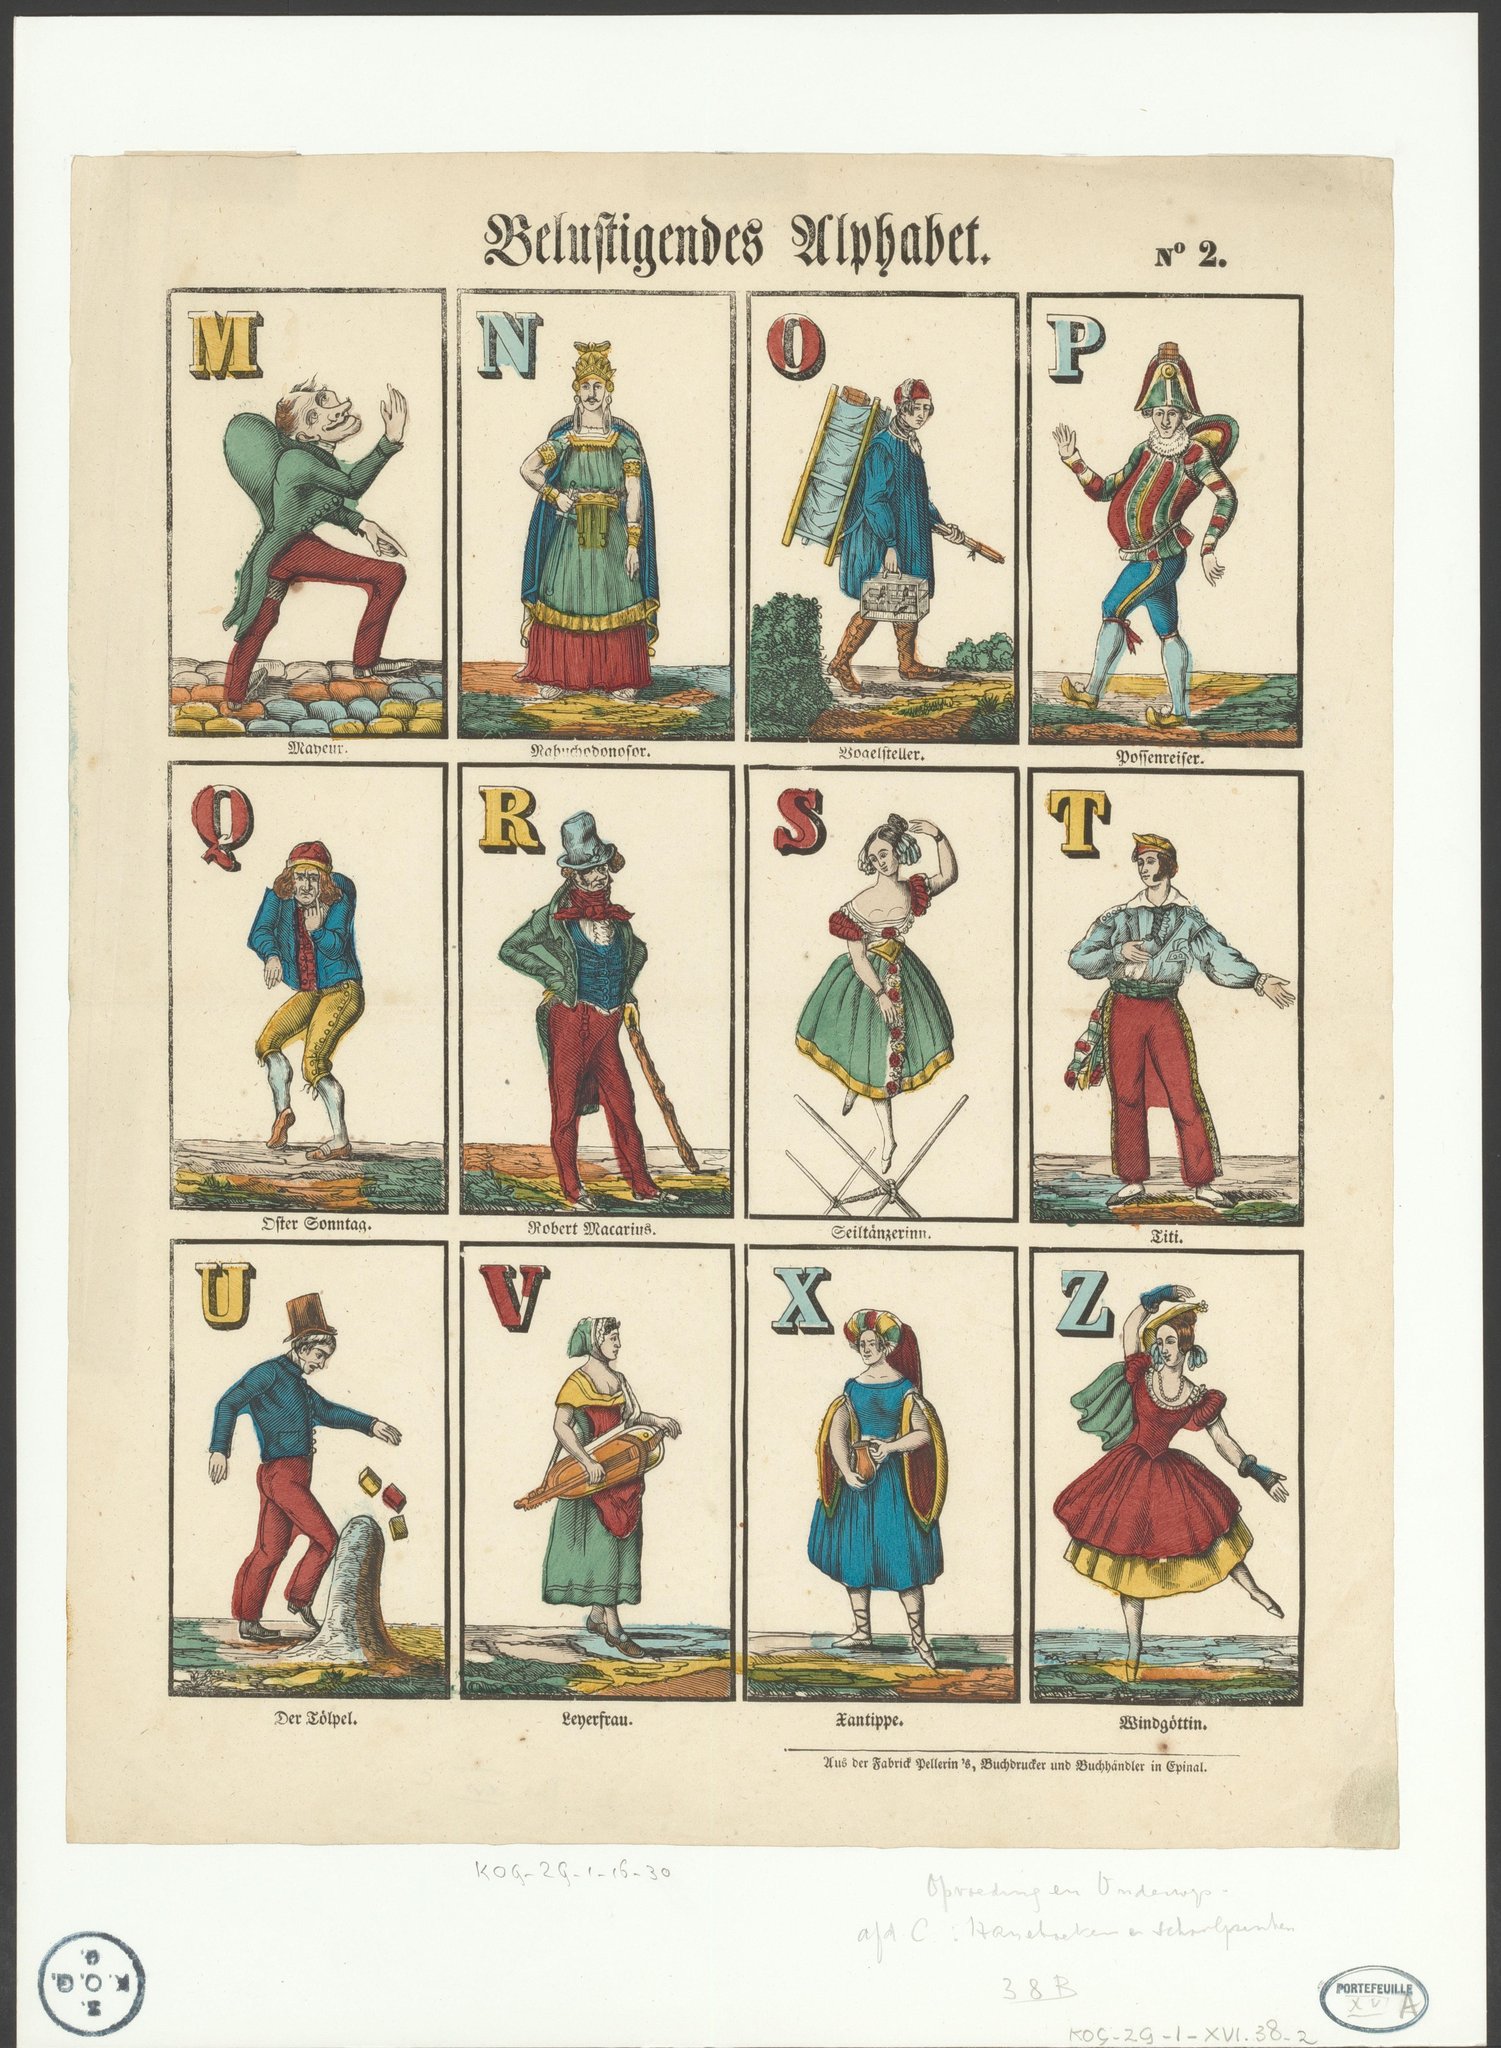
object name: popular print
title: Vermakelijk alfabet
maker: Anonymous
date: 1800-1849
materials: paper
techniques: hand coloring, engraving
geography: epinal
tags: caricatures (human types), letters, alphabet, script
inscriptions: collector's mark: Lugt 1641, stamp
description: Blad met twaalf voorstellingen een letter van het alfabet (M t/m Z) en een type. De afgebeelde types zijn onder andere: een vogelverkoper, een koorddanser en Xantippe. Genummerd rechtsboven: No. 2. Onderwerpsrubrieken binnen de Atlas Zeden en Gewoonten: Onderwijs en Wetenschappen, Opvoeding en Onderwijs, Haneboeken en schoolprenten.